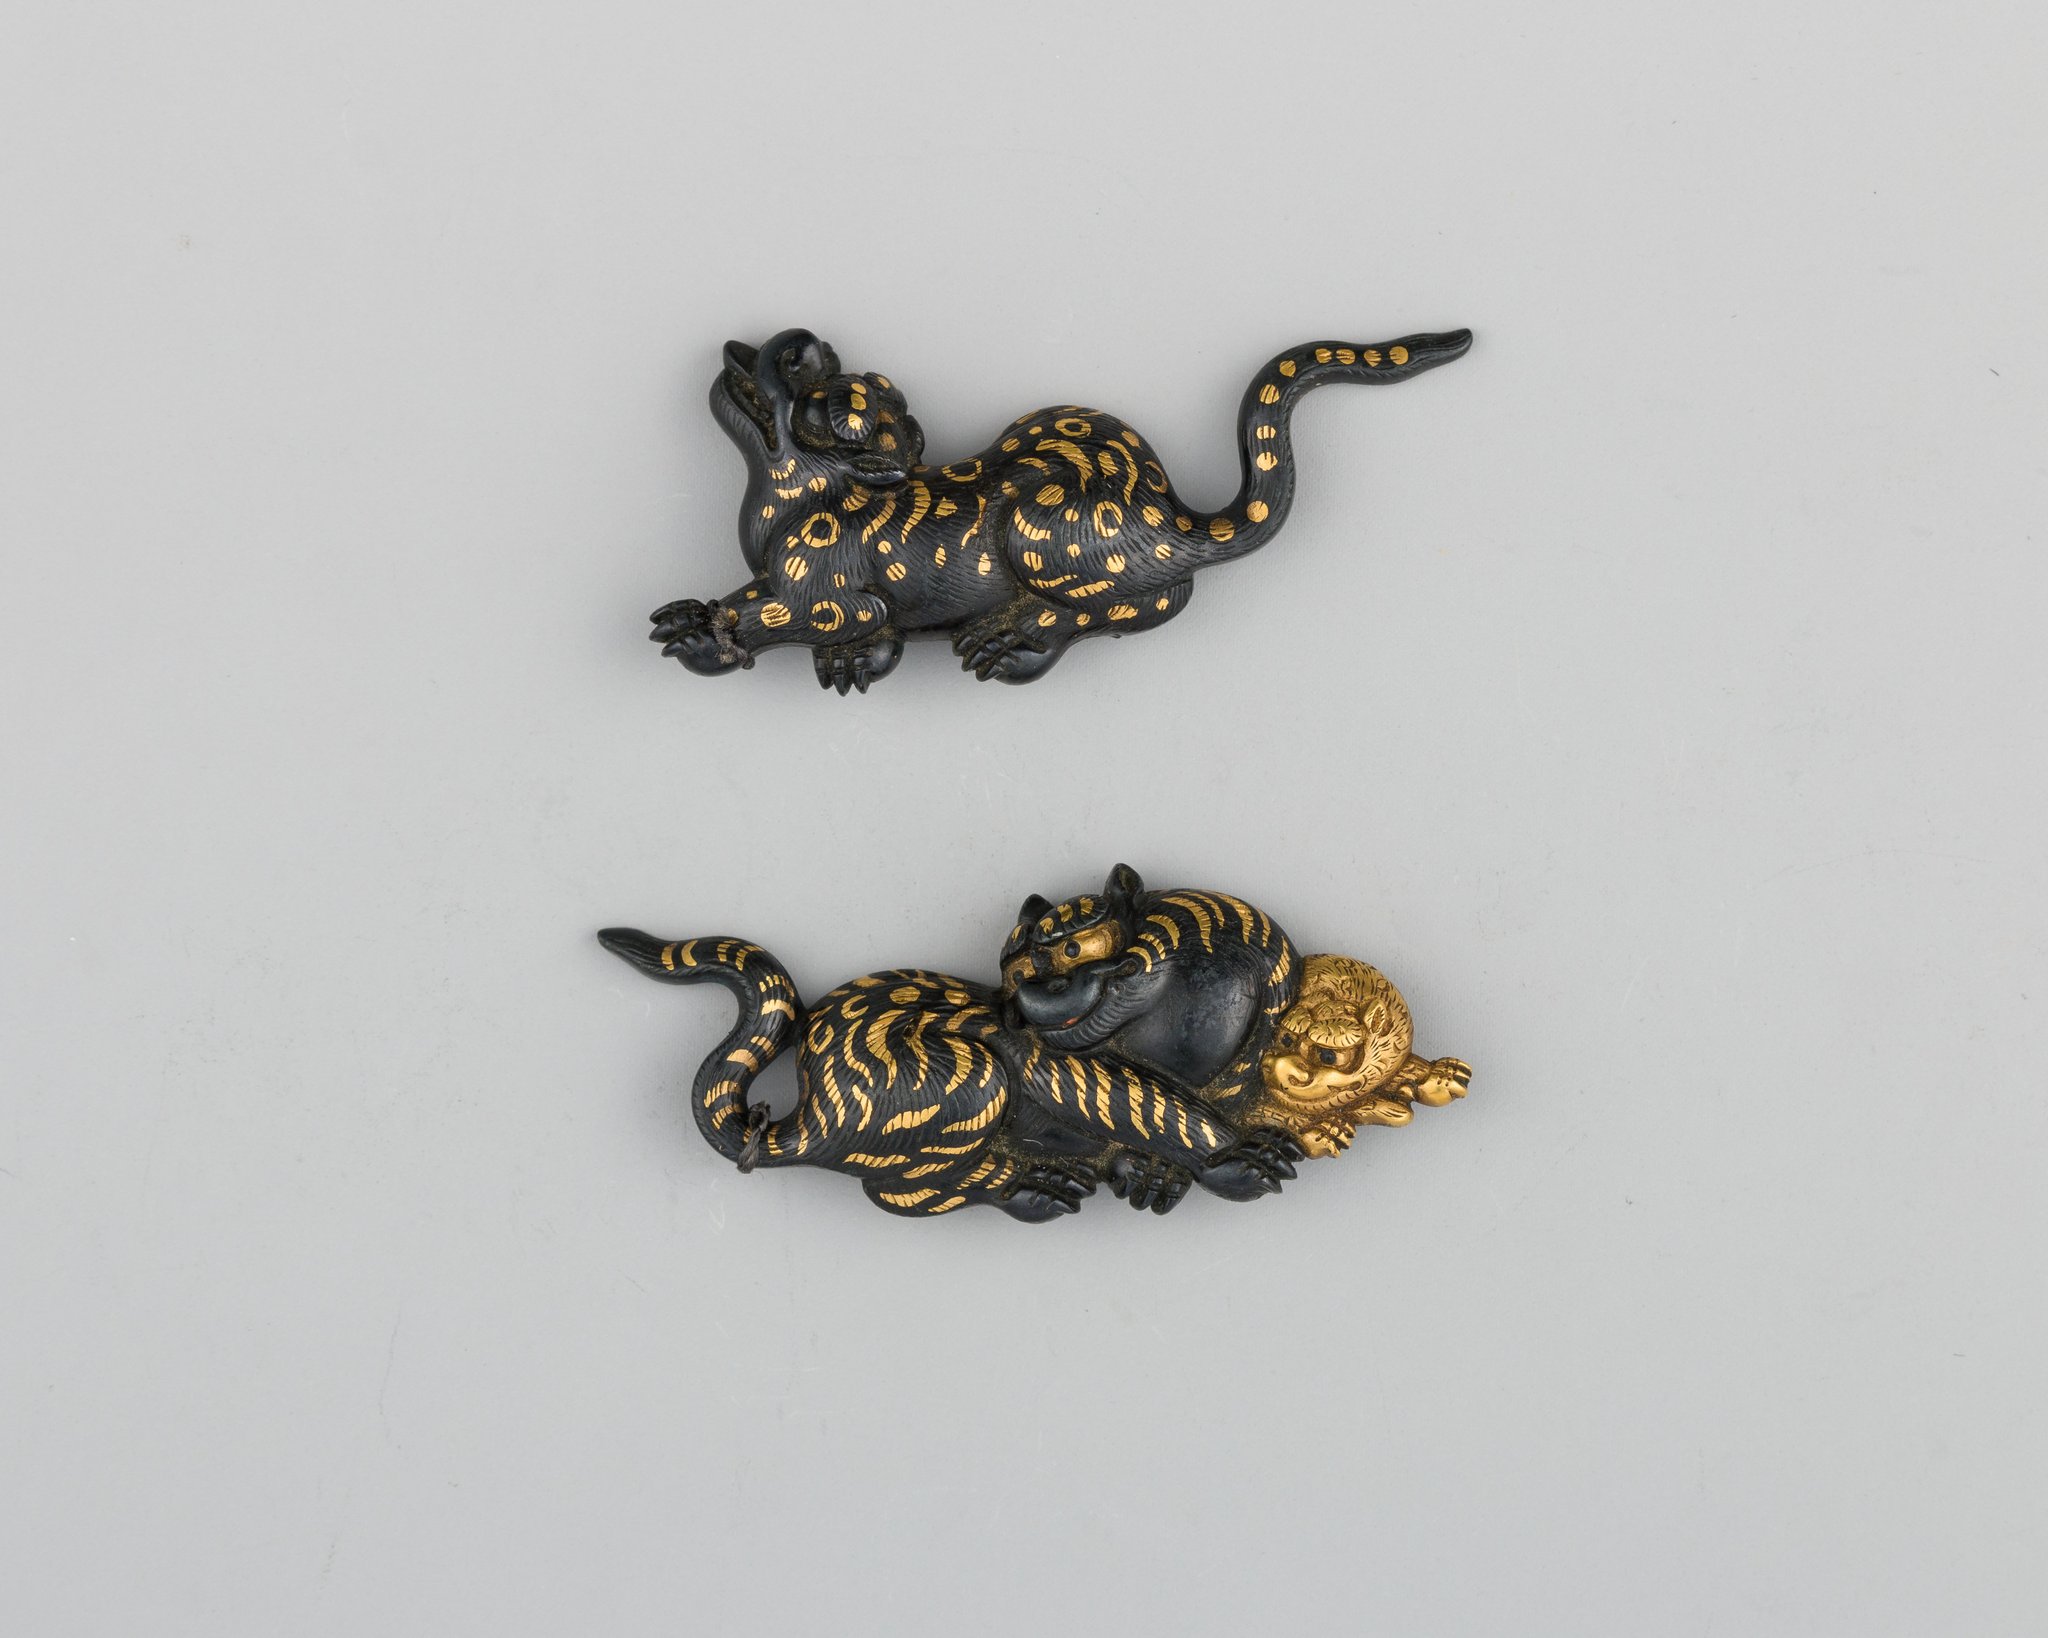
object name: pair of sword grip ornament menuki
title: Pair of Sword-Grip Ornaments (Menuki)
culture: japanese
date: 1701-1800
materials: copper, gold alloy, gold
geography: japan